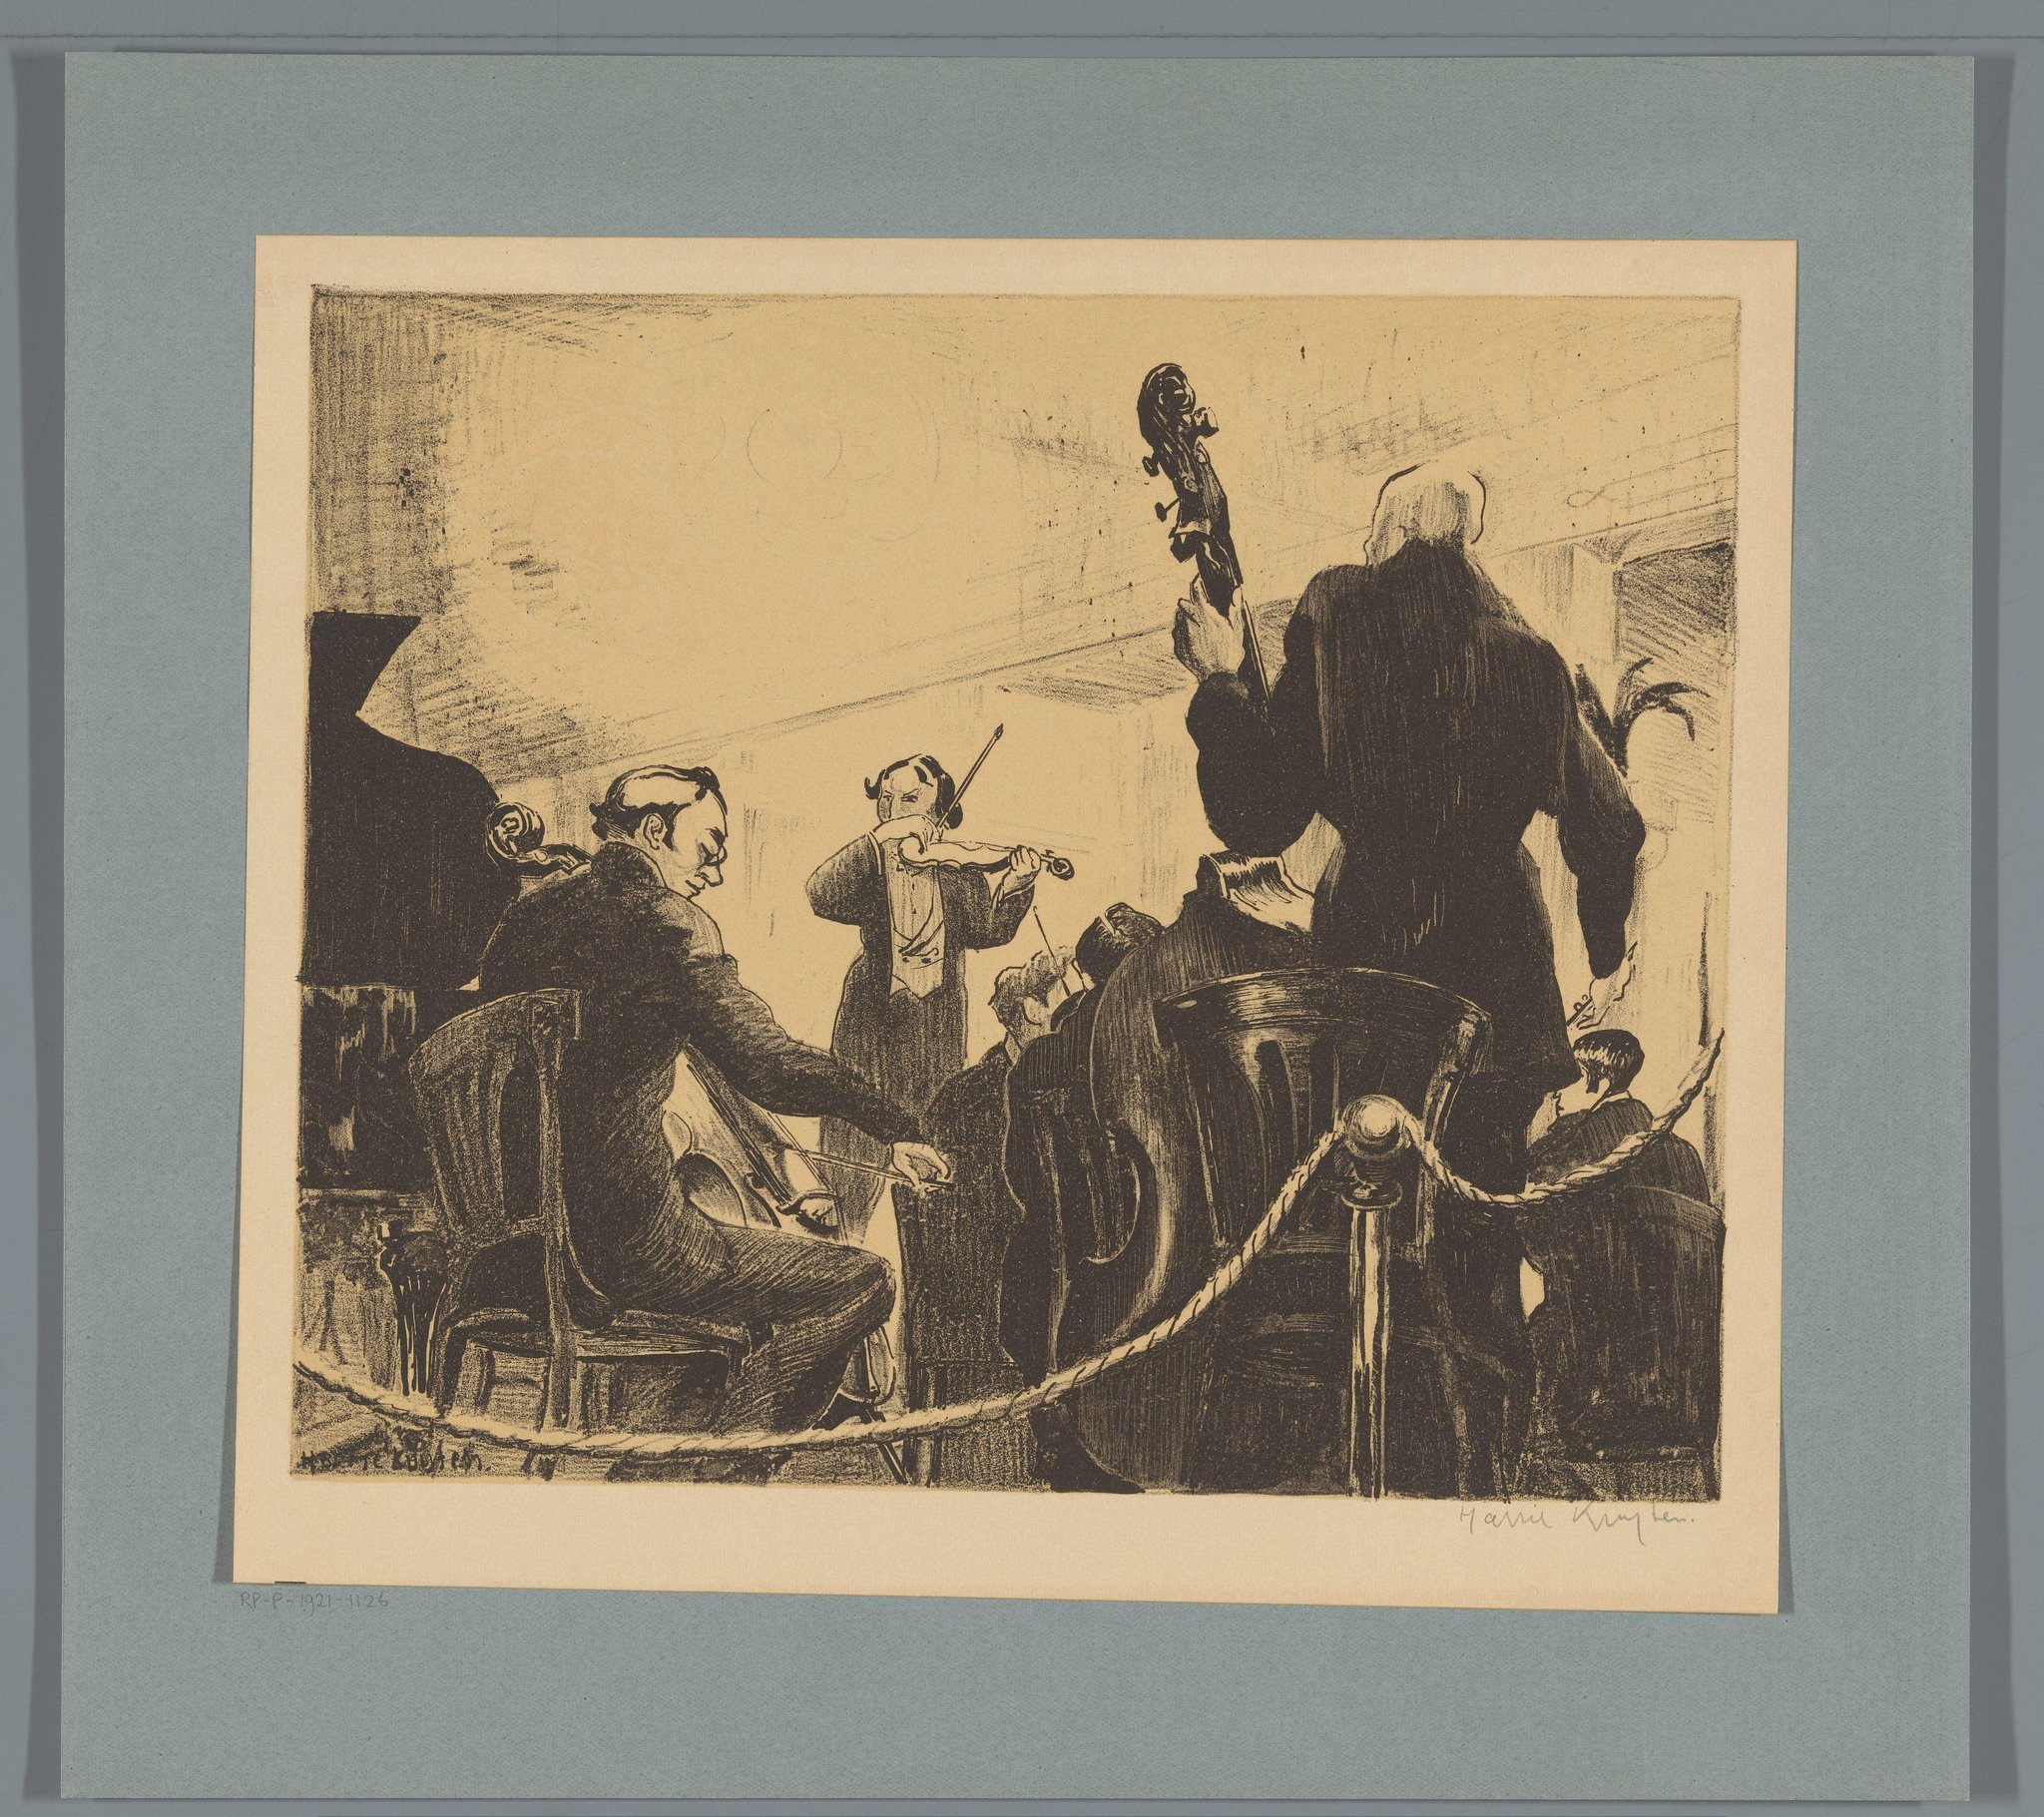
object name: print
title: Violist in orkest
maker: harrie kuyten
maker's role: print maker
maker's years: 1883-1952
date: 1893-1921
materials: paper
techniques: tone lithography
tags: large group of musicians, orchestra, violin, fiddle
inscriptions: collector's mark: Lugt 2233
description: Tussen de muzikanten van het orkest door is een staande violist te zien. Deze prent maakt deel uit van een omslag met zes prenten.